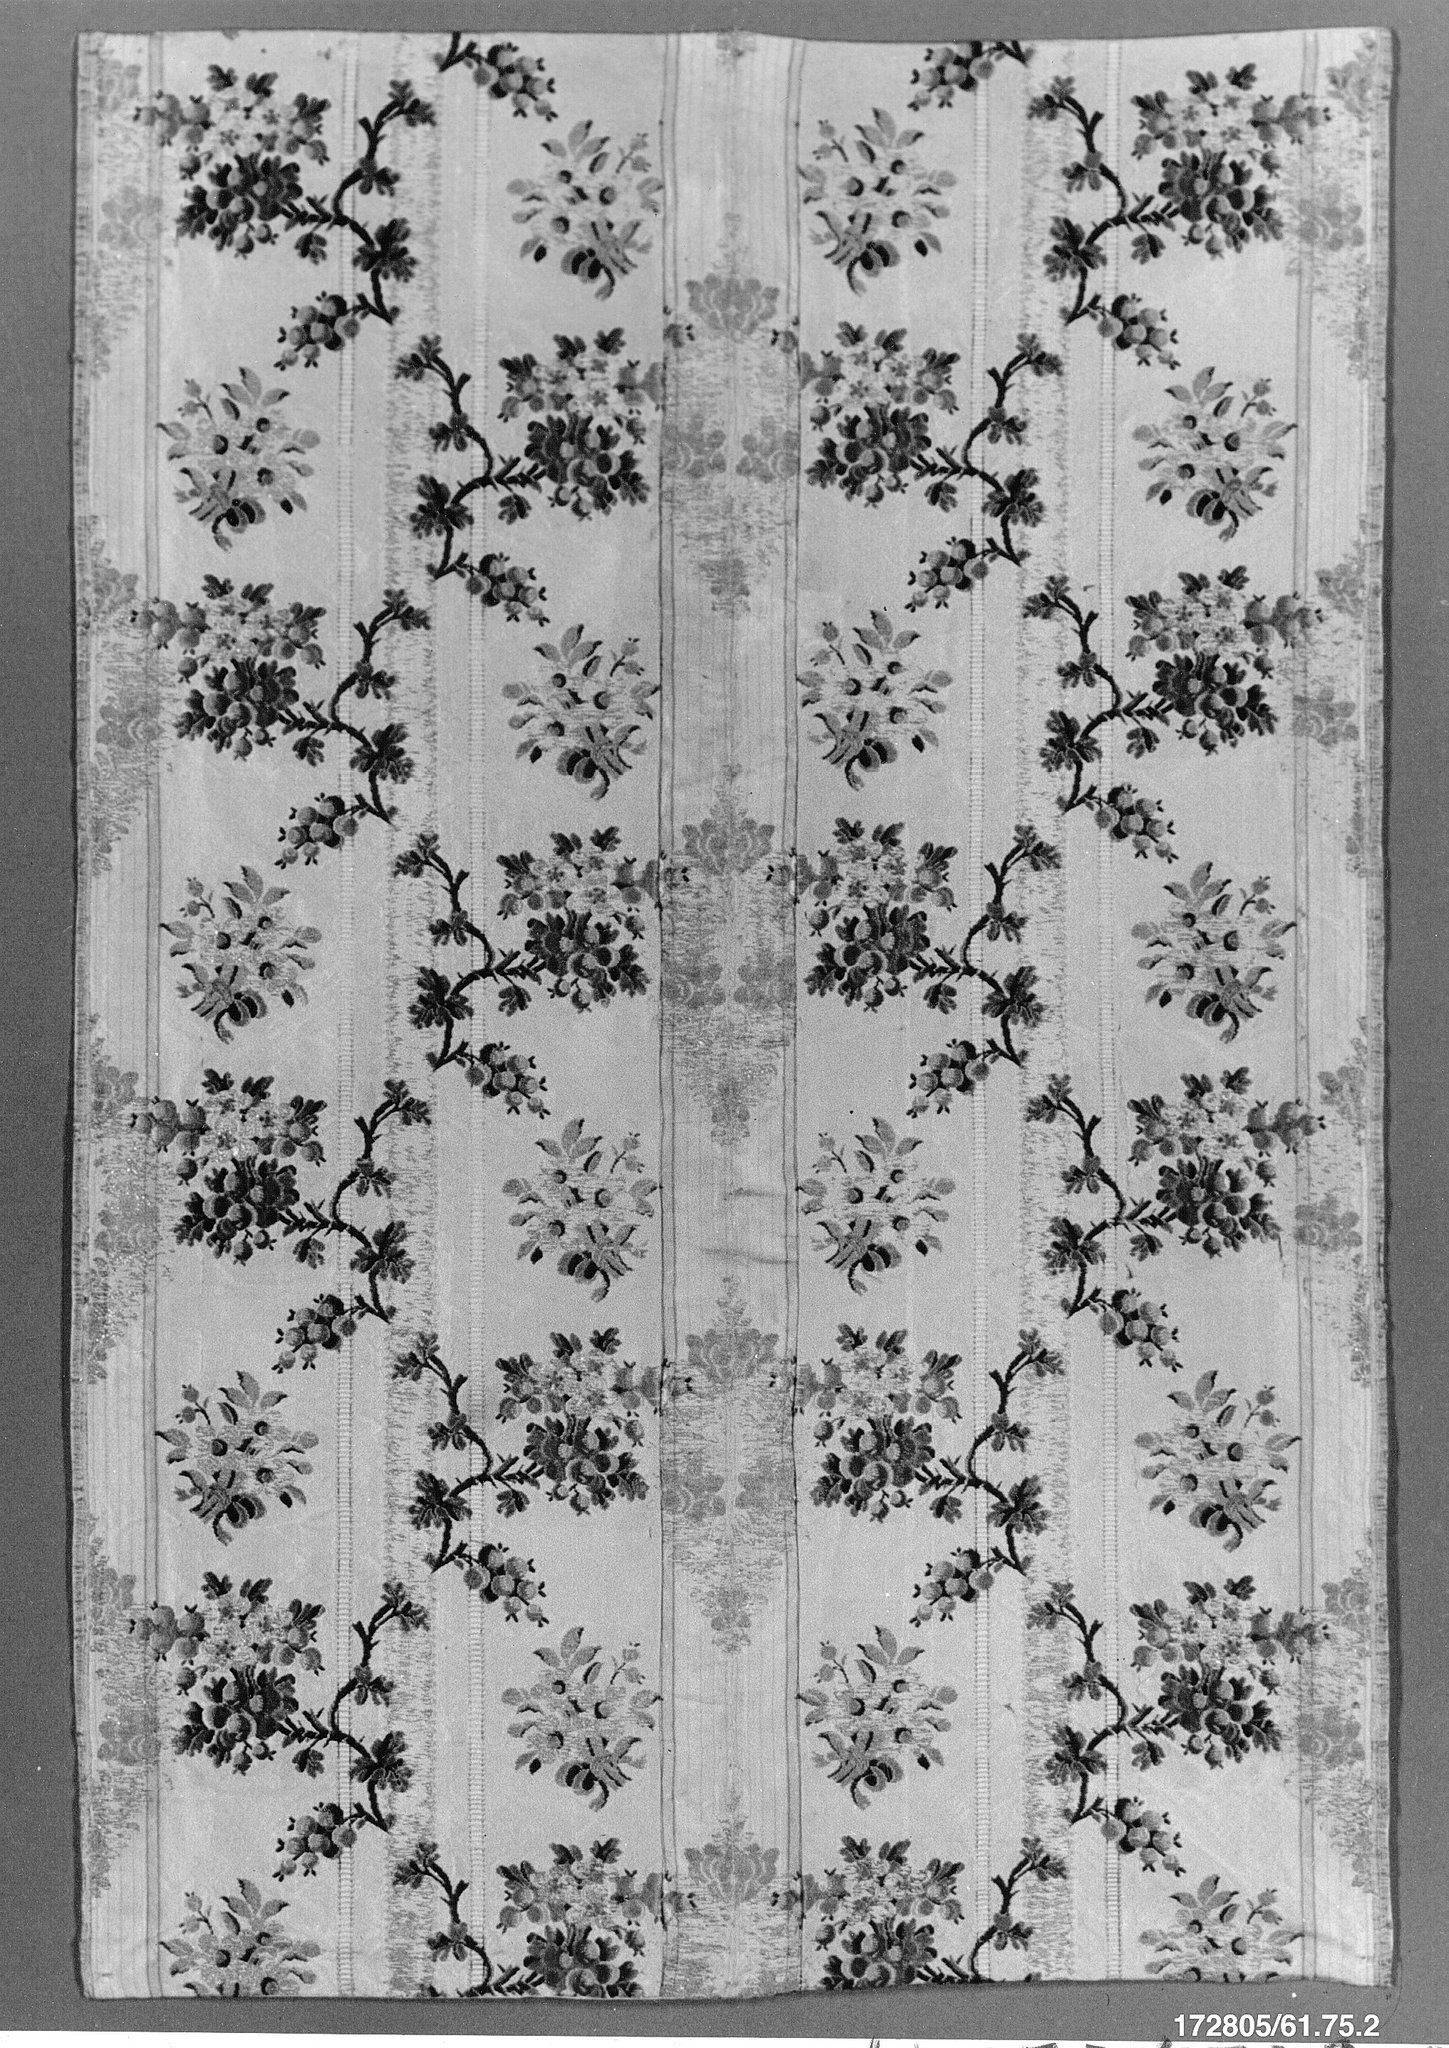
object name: panel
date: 1701-1800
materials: metal thread, silk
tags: flowers